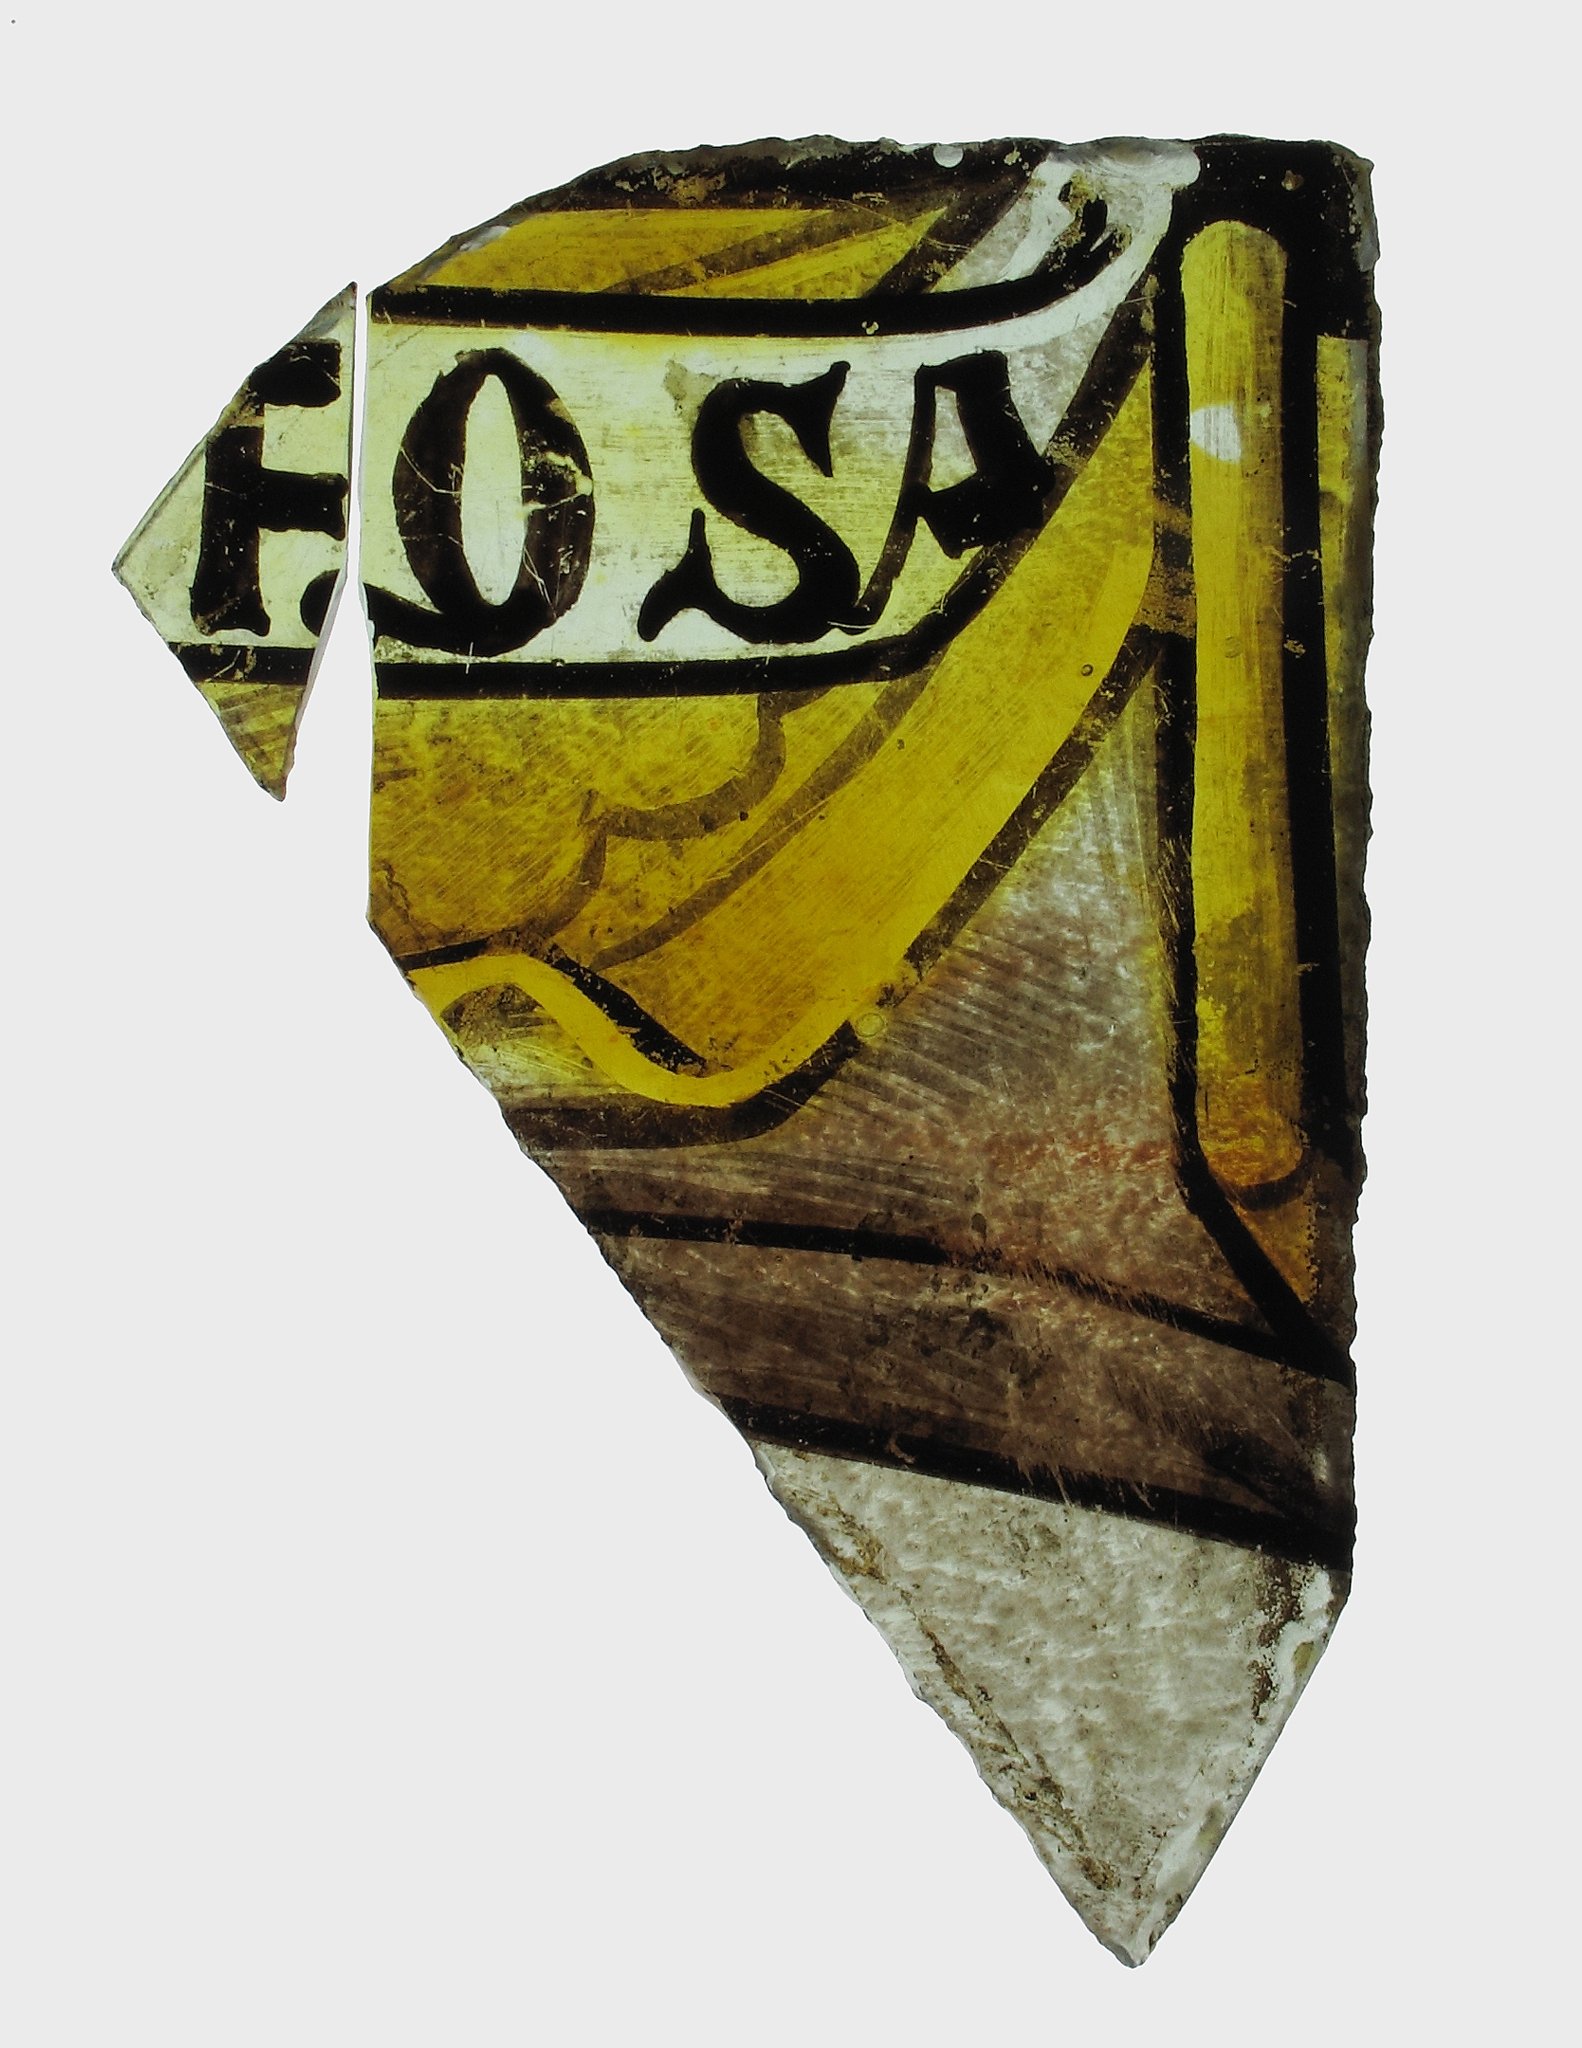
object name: fragment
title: Glass Fragment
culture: spanish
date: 1501-1600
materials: glass